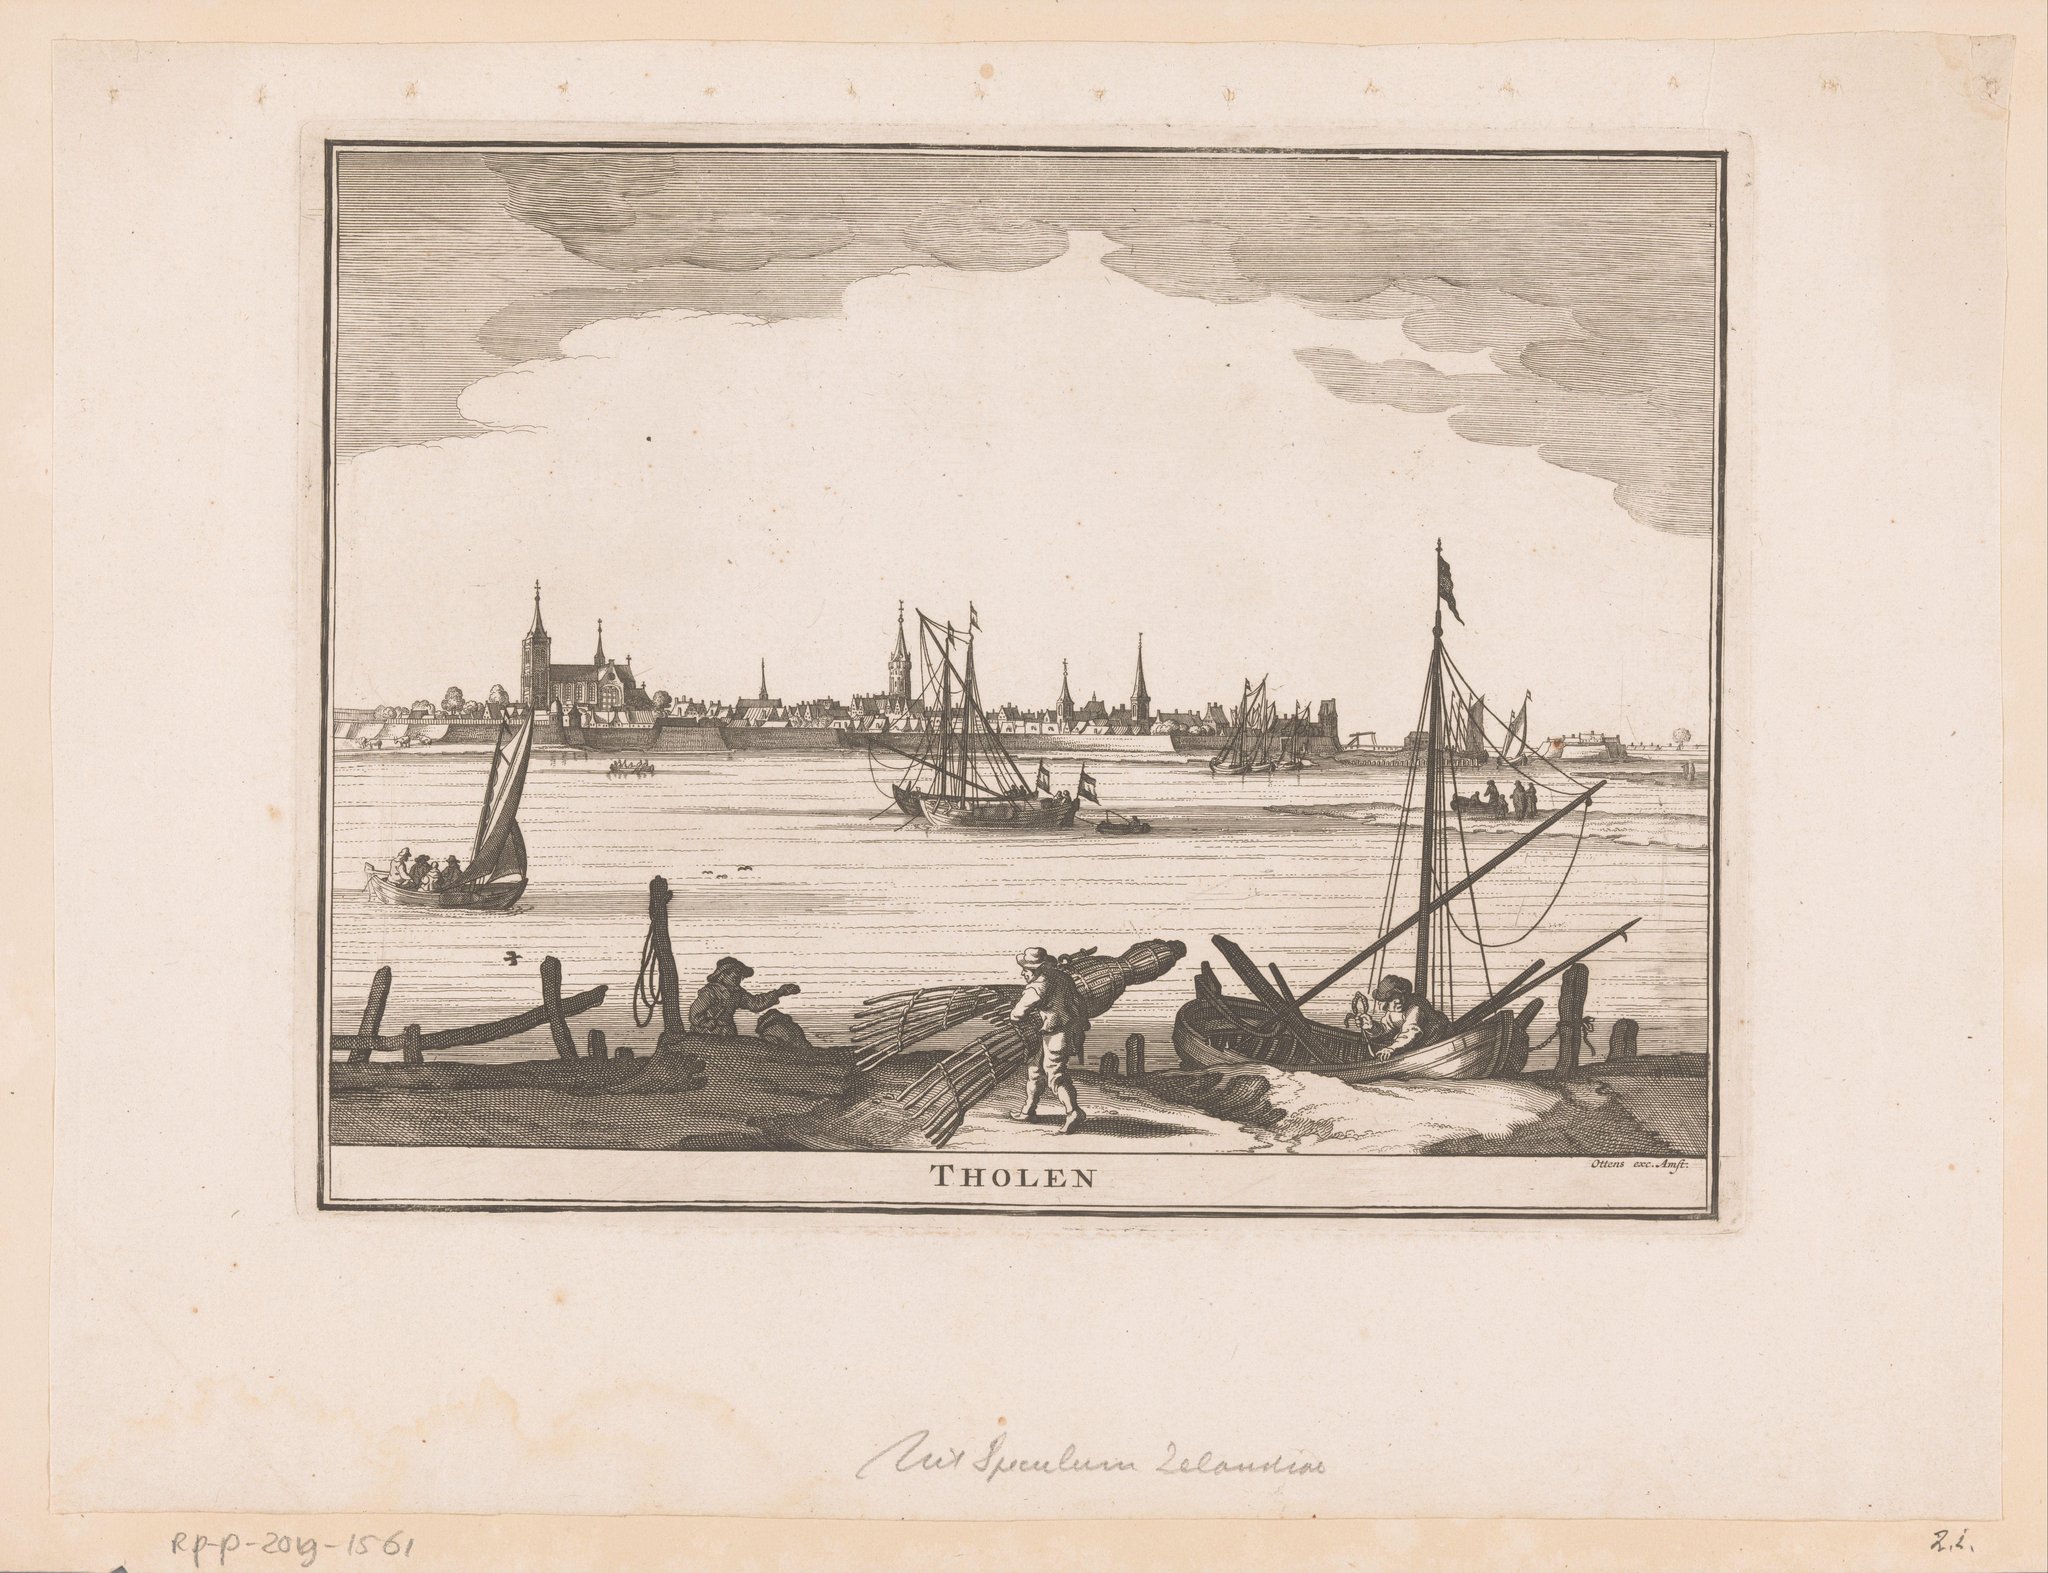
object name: print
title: Stads- en dorpsgezichten in Zeeland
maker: pieter hendricksz. schut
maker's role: print maker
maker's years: 1618-1660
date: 1720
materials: paper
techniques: etching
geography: amsterdam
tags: river (+ landscape with figures, staffage), prospect of city, town panorama, silhouette of city (+ city(-scape) with figures, staffage)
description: Prent uit: Speculum Zelandiae dat is: een beschryvinge ofte afbeelding der steden (...). Amsterdam: Weduwe Ottens en zonen, [ca. 1720]. Prent werd eerder uitgegeven in publicaties van Zacharias Roman en Nicolaes Visscher vanaf ca. 1656.